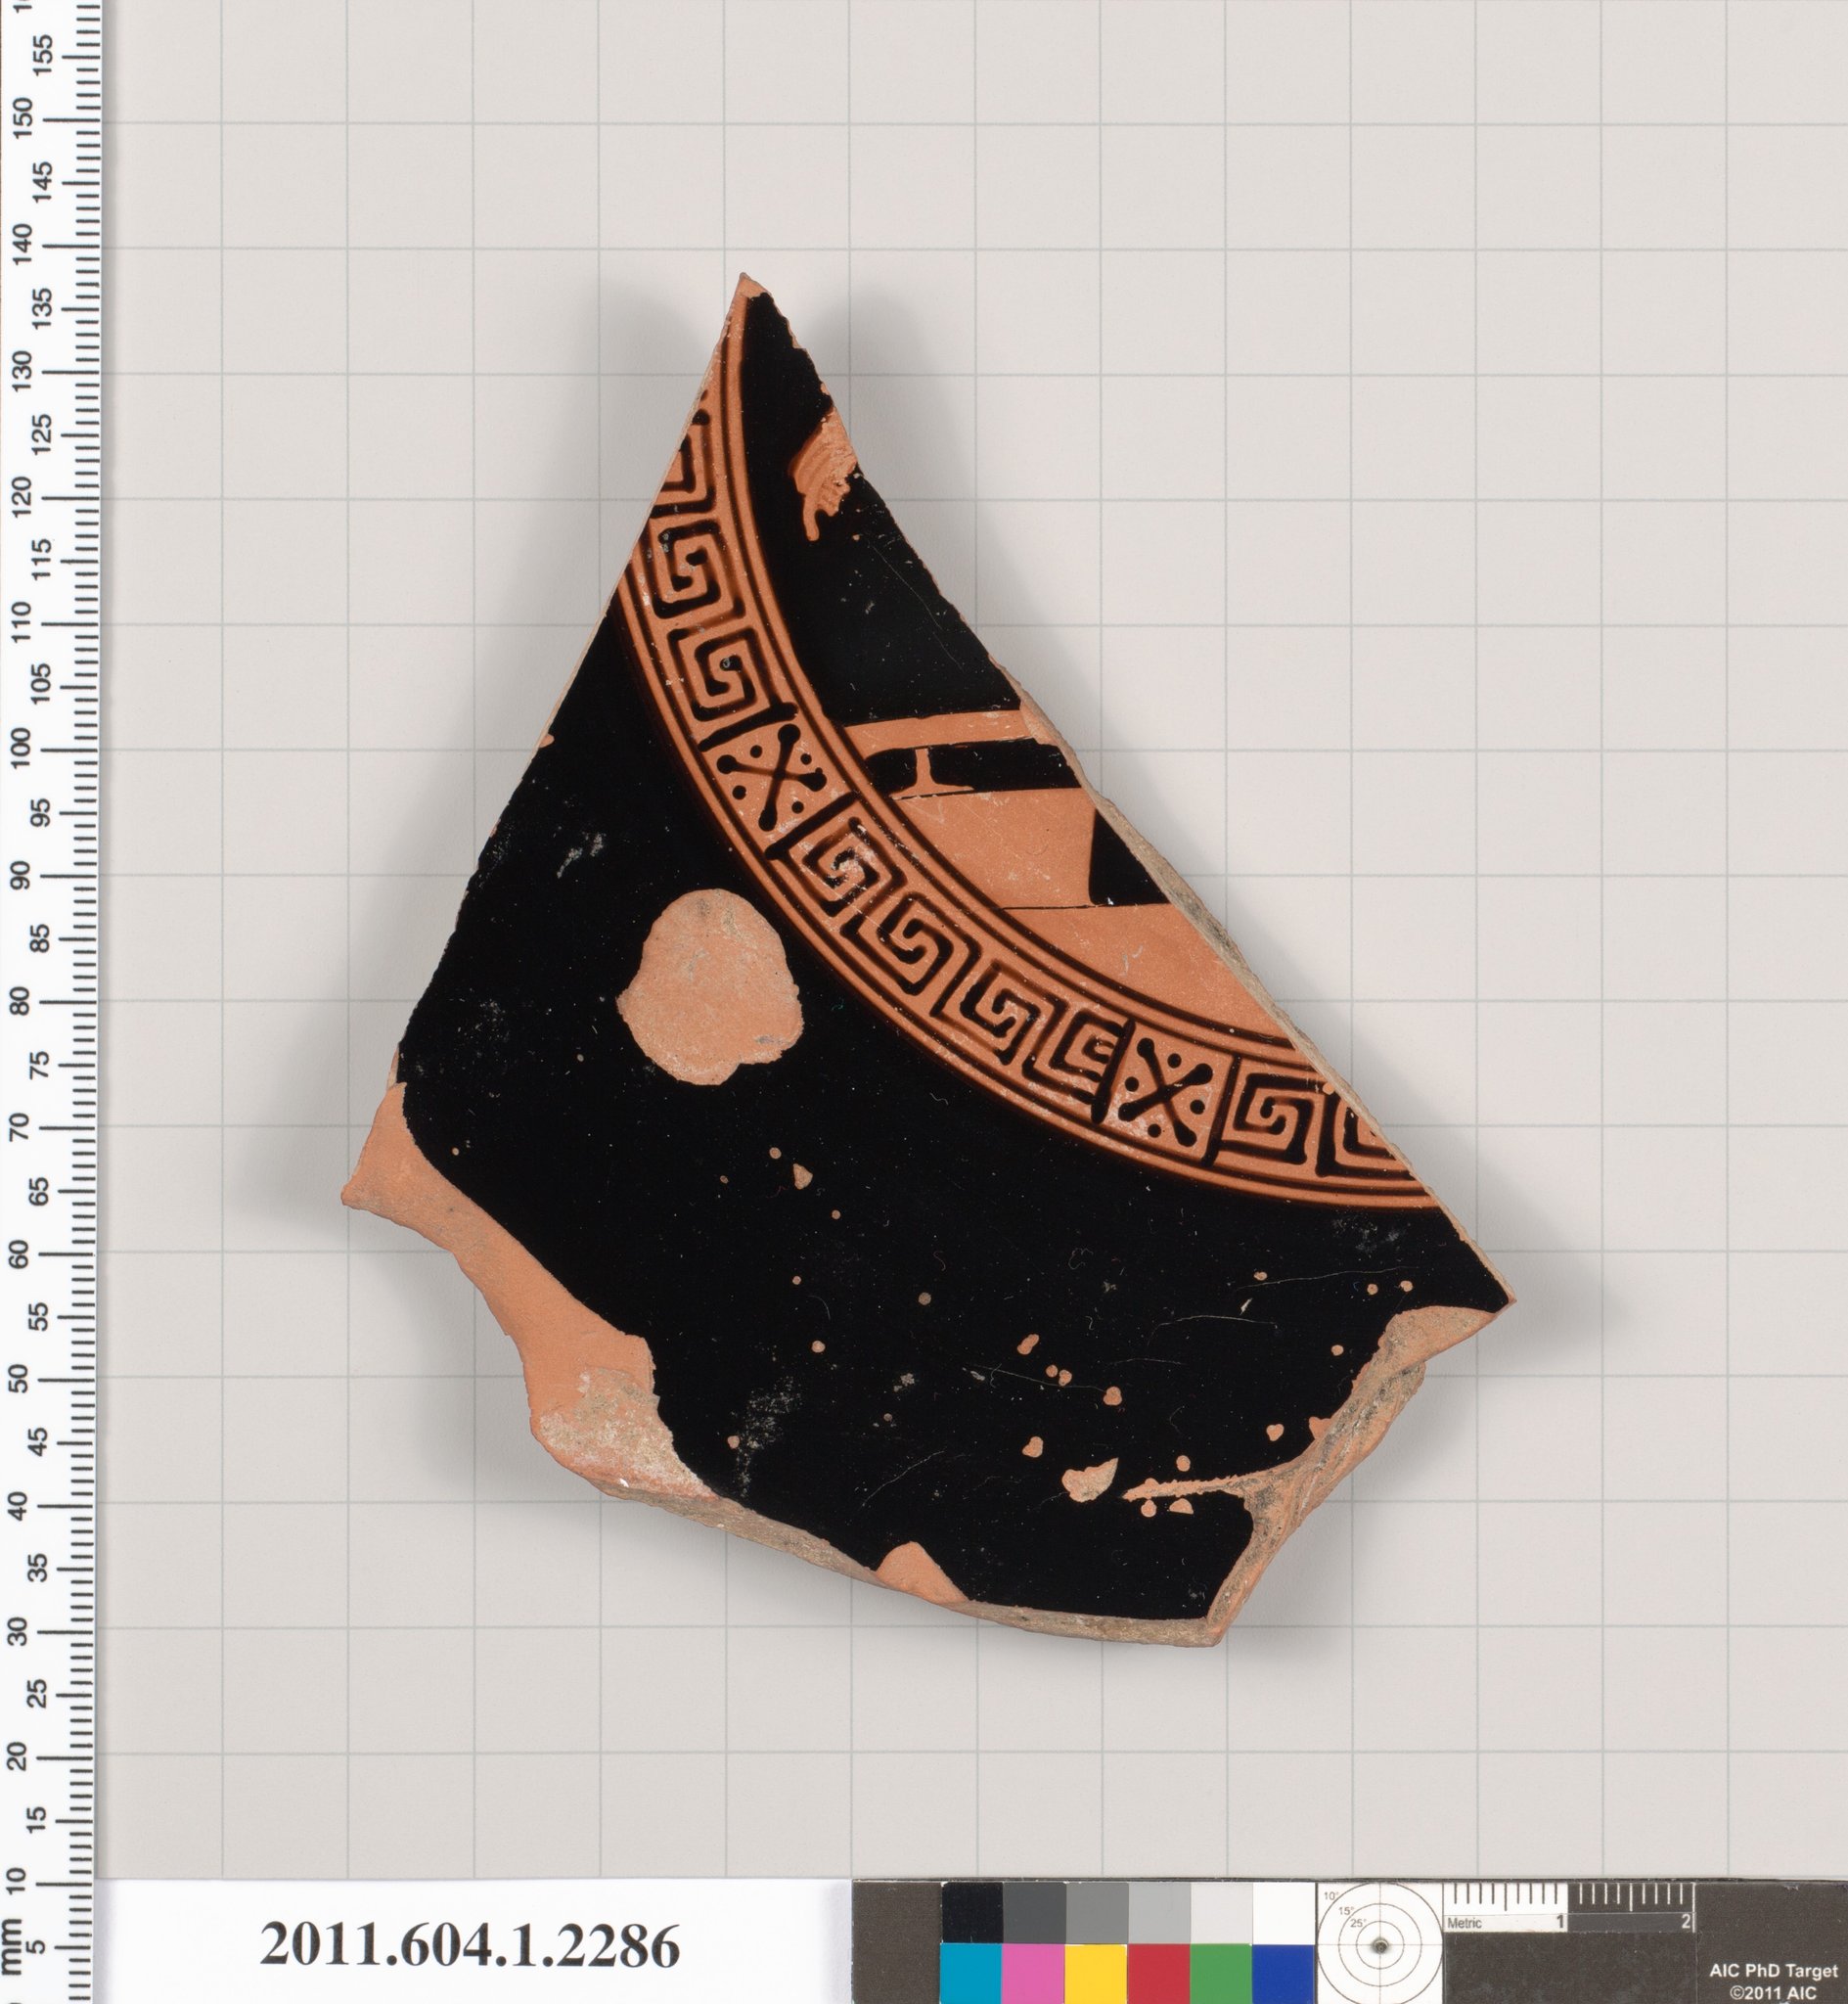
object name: kylix fragment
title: Terracotta fragment of a kylix (drinking cup)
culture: greek, attic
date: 475-451 BCE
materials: terracotta